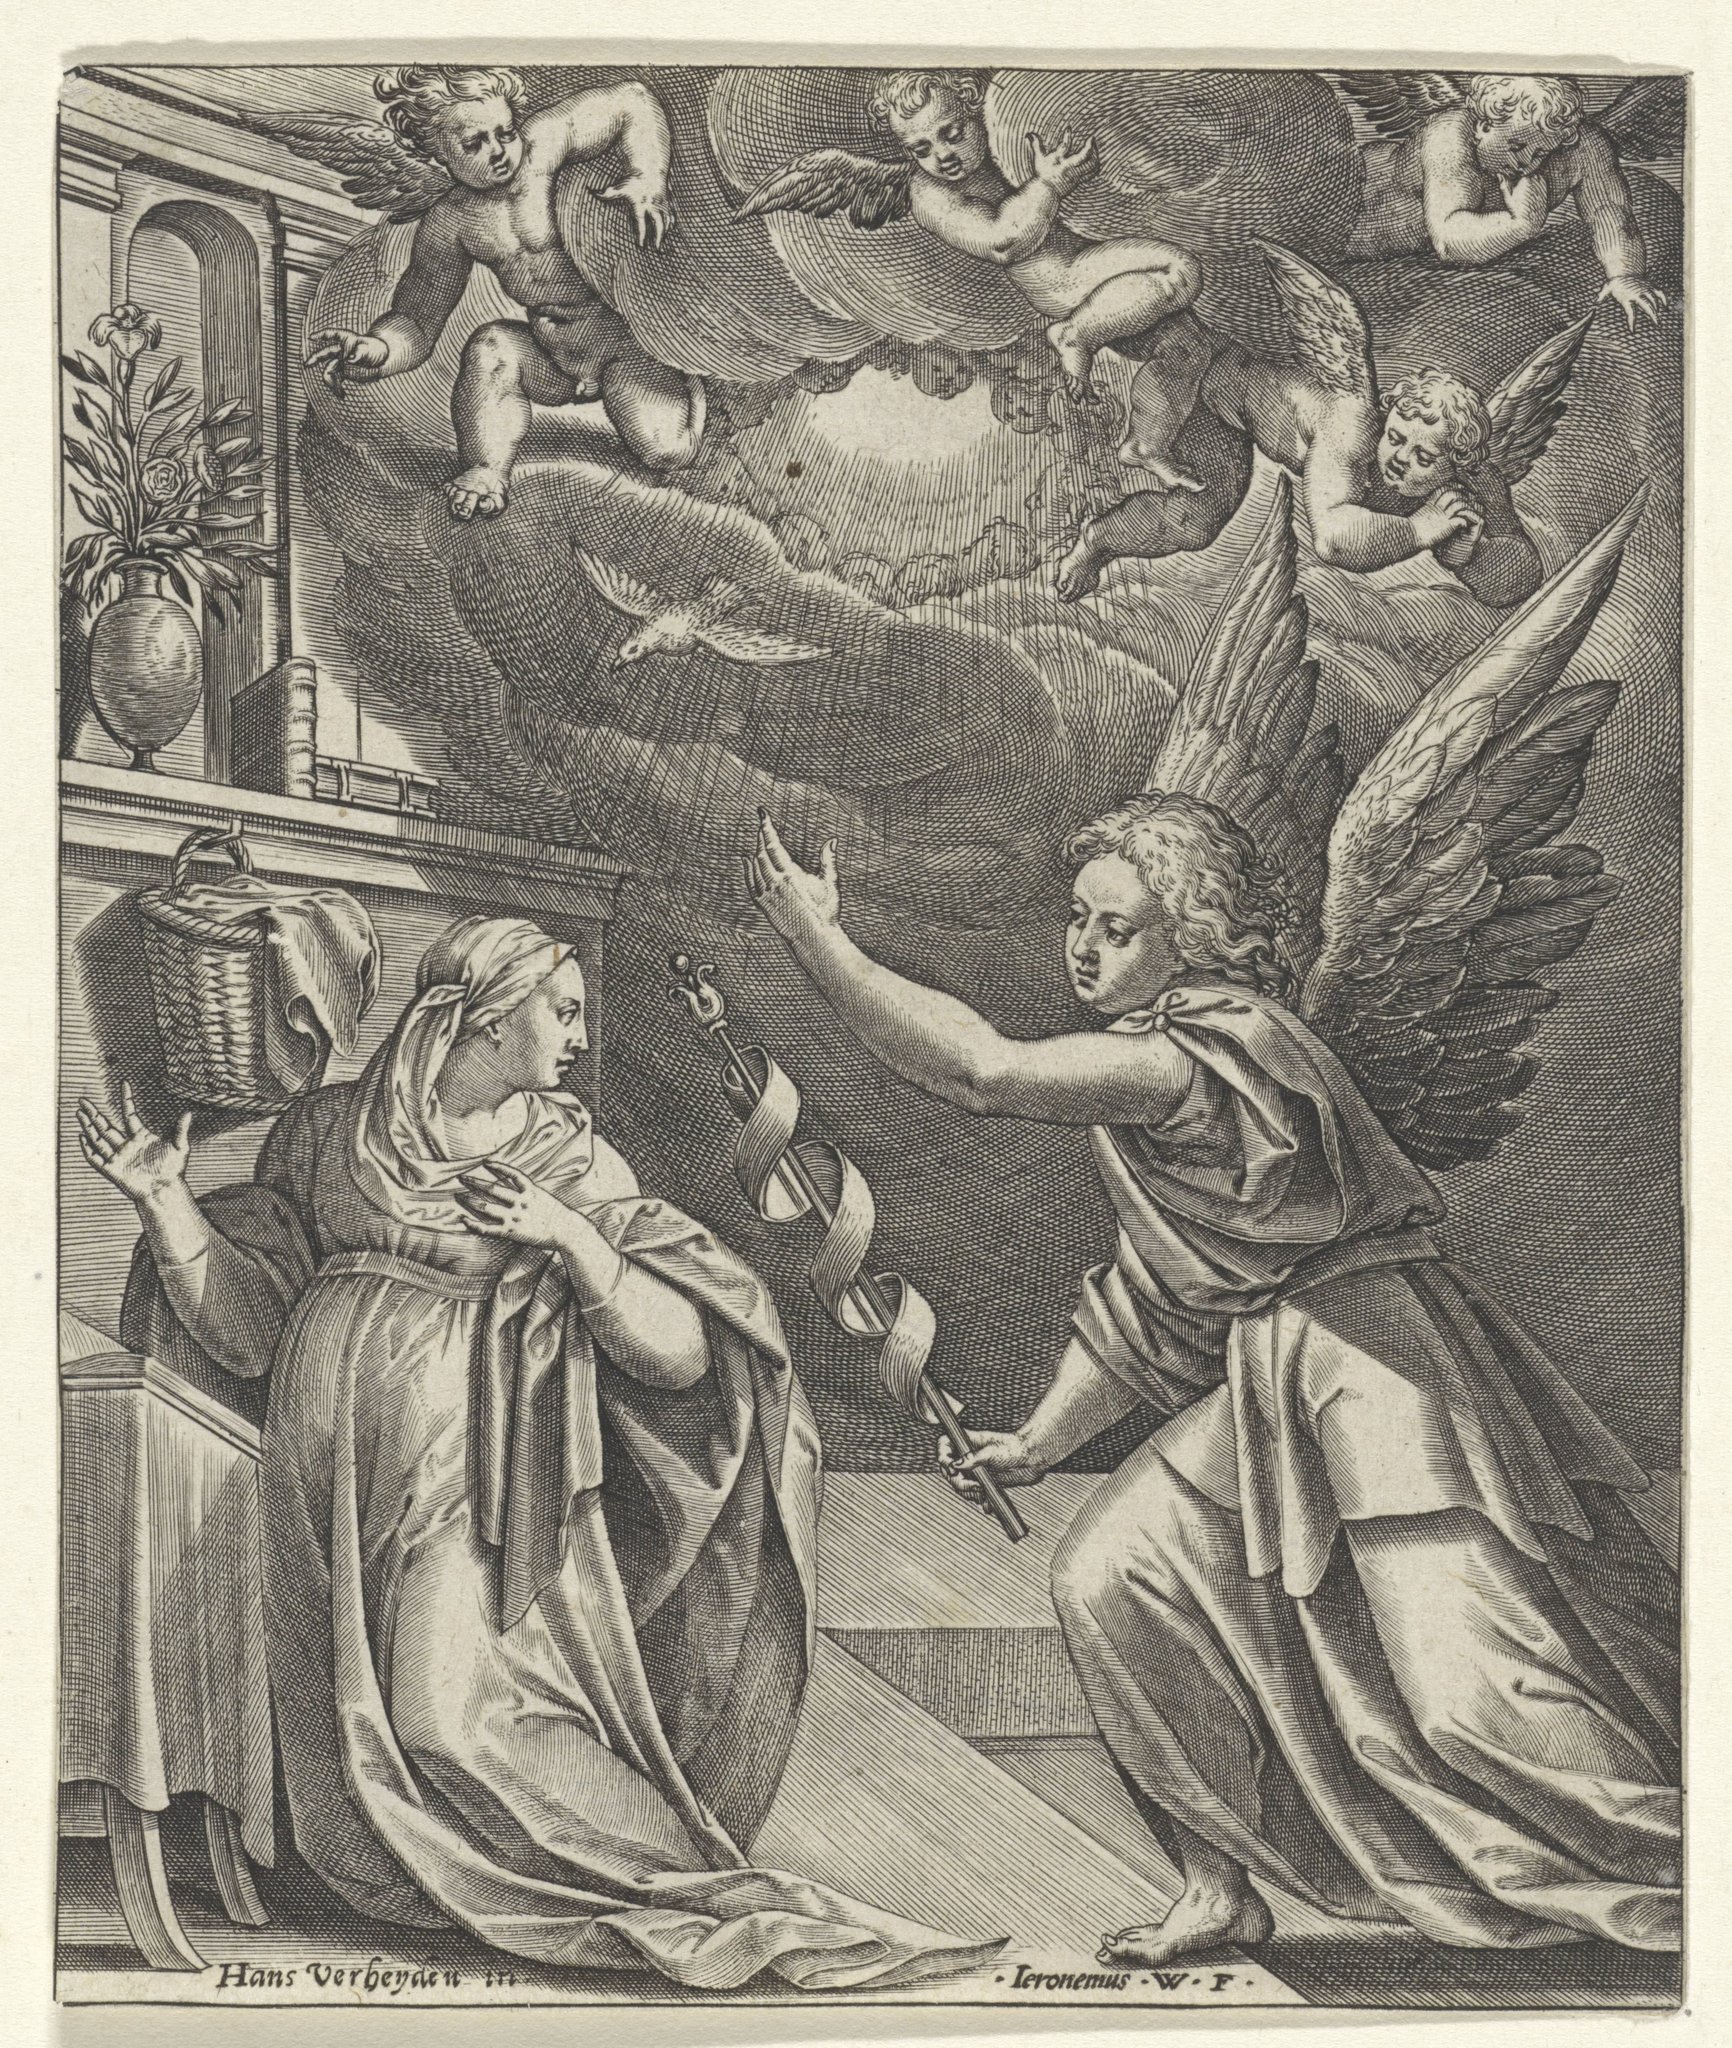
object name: print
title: Annunciatie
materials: paper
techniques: engraving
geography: antwerp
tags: the annunciation: mary, usually reading, is visited by the angel (sometimes a woman overhears the conversation)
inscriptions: collector's mark: Lugt 2228, collector's mark: Lugt 2542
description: Maria zit geknield aan haar lessenaar. Ze kijkt over haar schouder naar de engel Gabriël. Hij vertelt haar dat ze een zoon zal baren die Christus zal heten. Boven hen engeltjes en de duif als symbool voor de Heilige Geest.